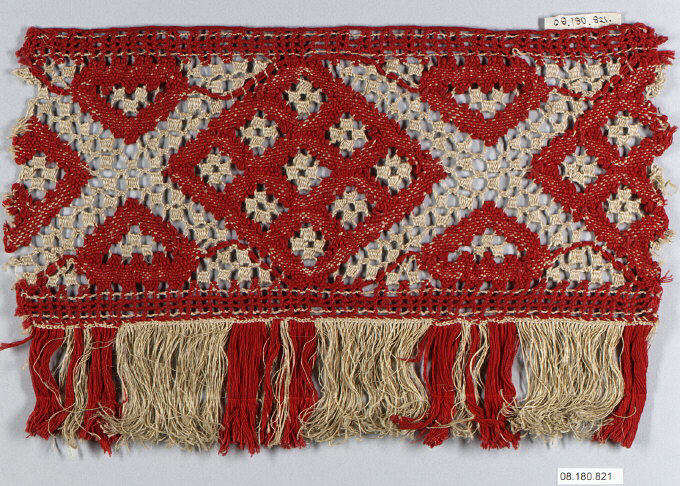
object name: fragment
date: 1801-1900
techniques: lace